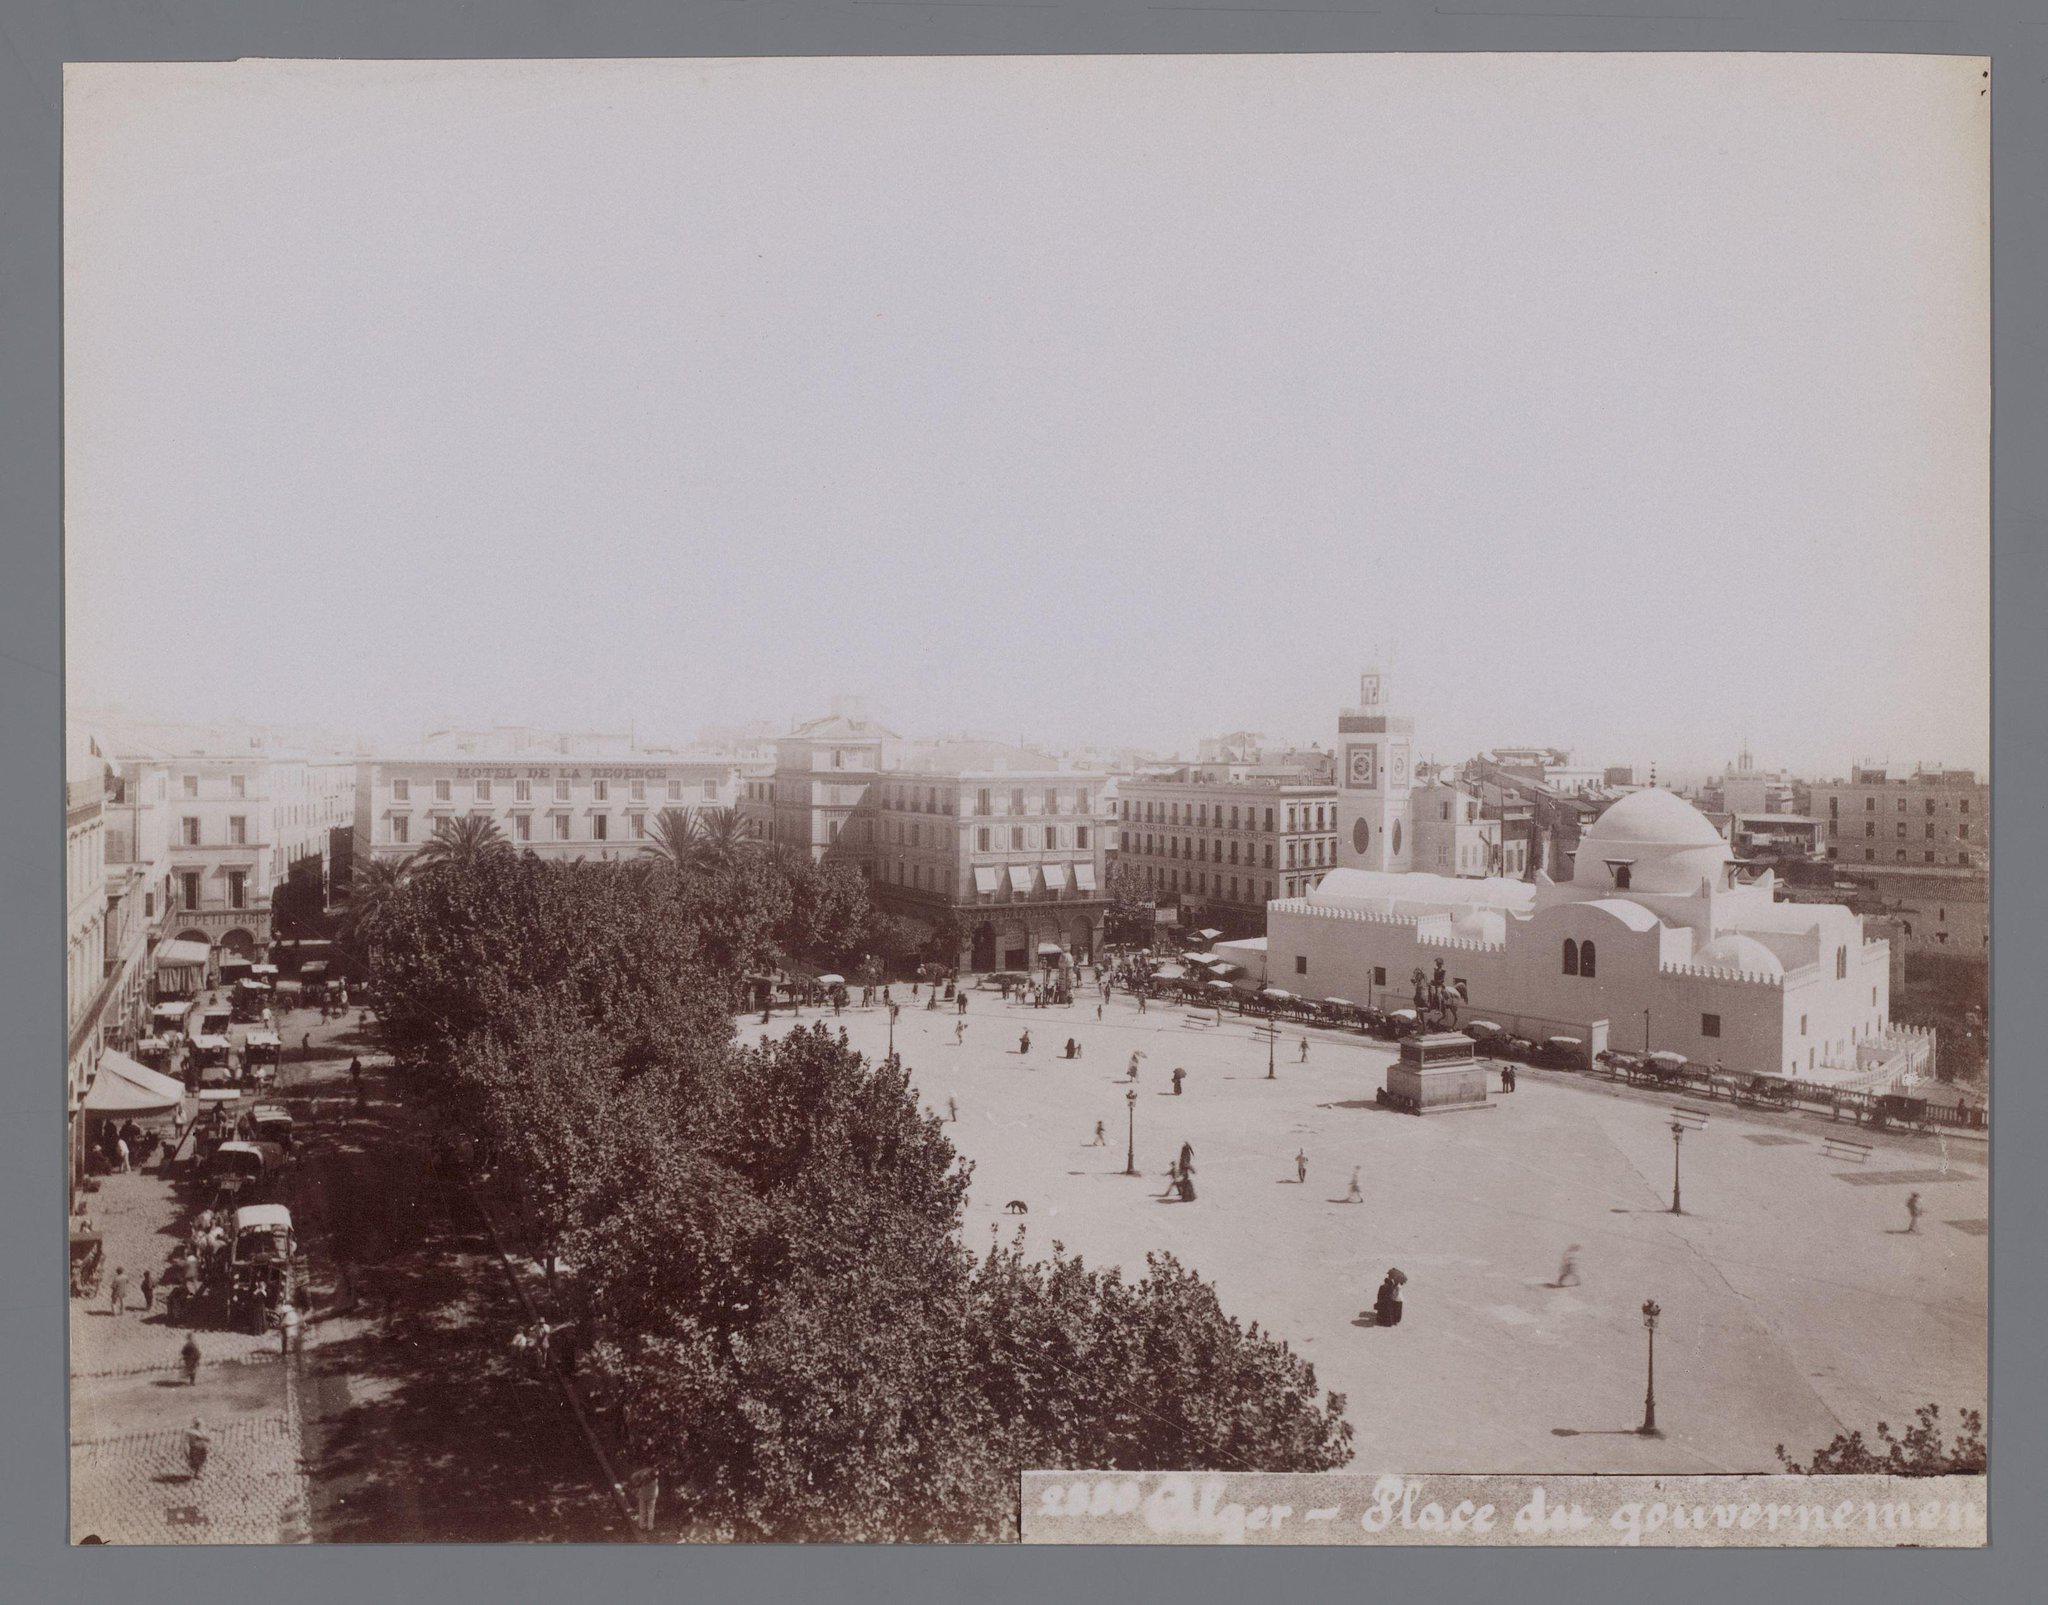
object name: photograph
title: Alger, place du gouvernement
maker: Anonymous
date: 1860-1900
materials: paper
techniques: albumen print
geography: algiers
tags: square, place, circus, etc., temple, shrine ~ islam, mohammedanism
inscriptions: number: ‘2330 [?]’